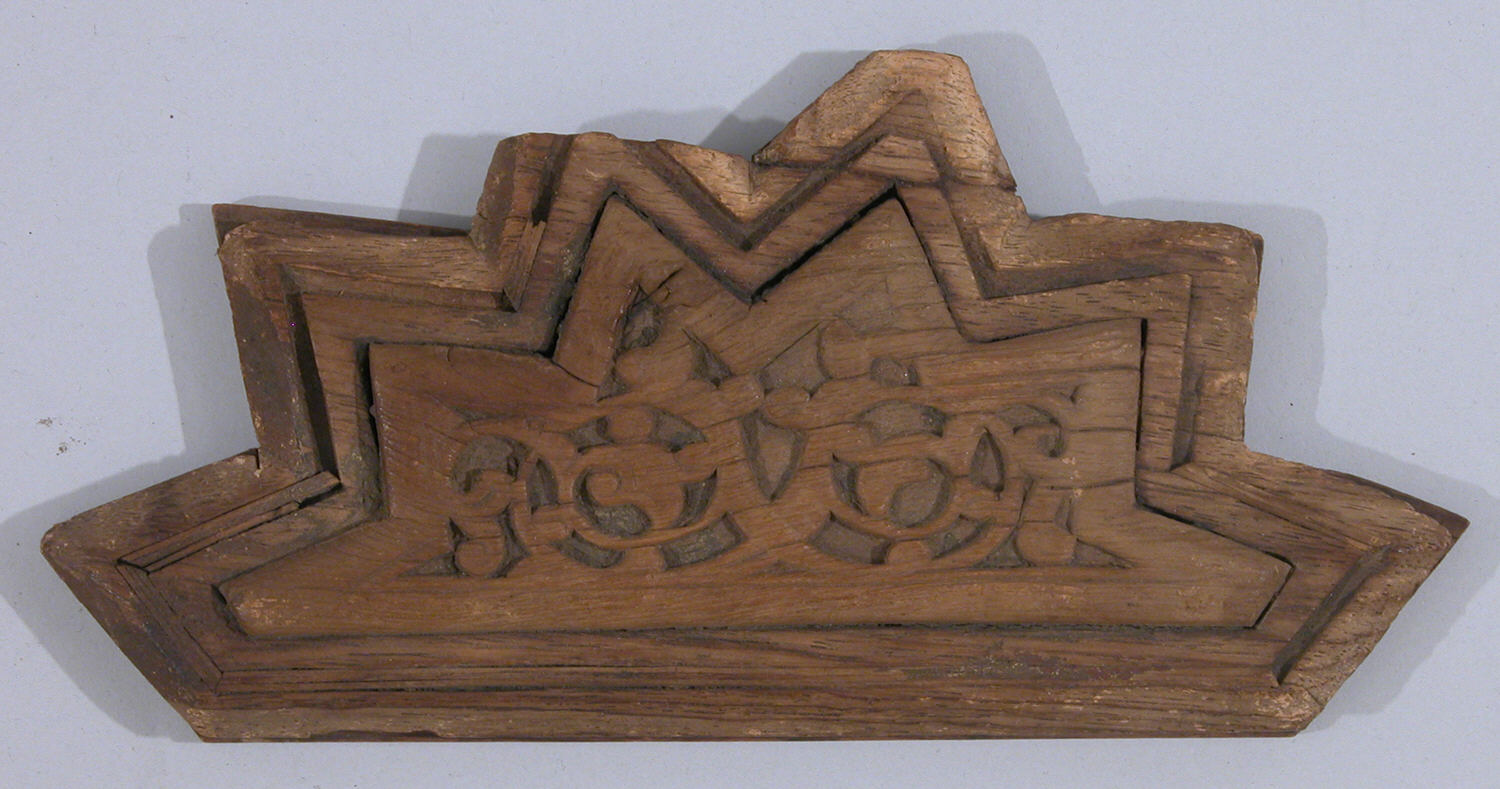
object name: panel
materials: wood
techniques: carving, inlay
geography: egypt